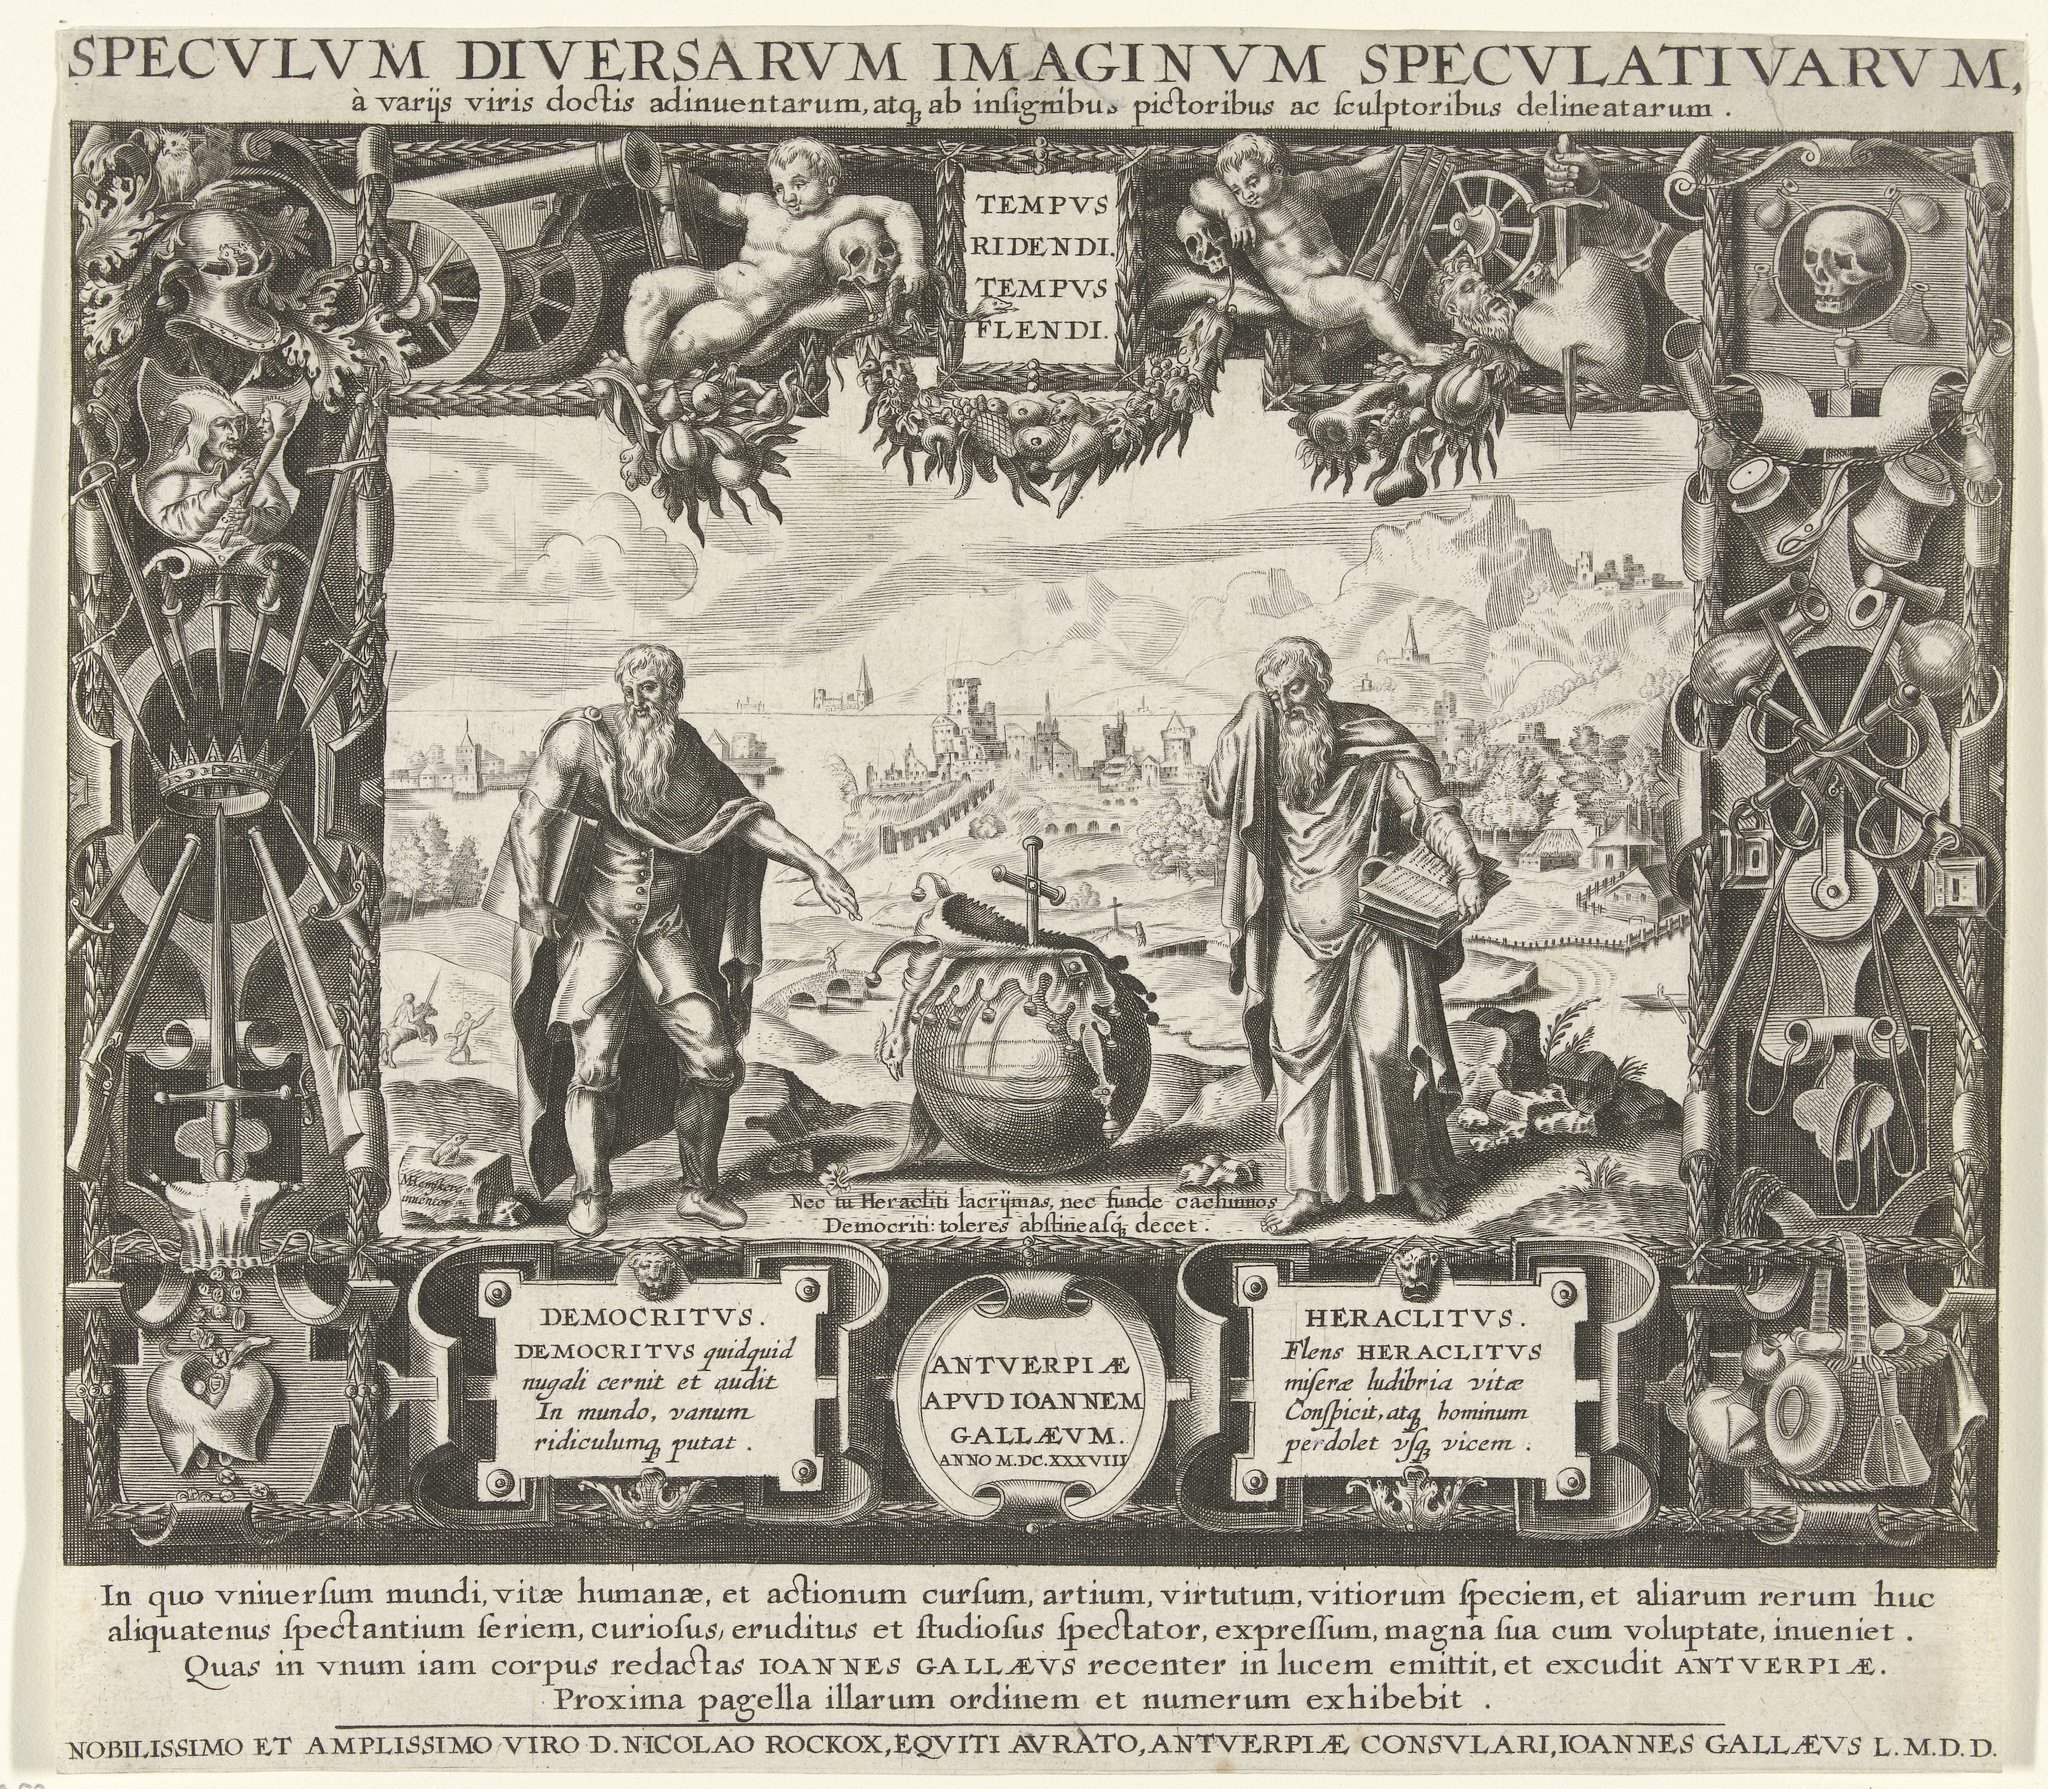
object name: print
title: Heraclitus en Democritus, of aansporing tot geduld en verdraagzaamheid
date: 1550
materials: paper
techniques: engraving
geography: haarlem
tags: fool, simpleton, numskull, folly, foolishness; 'pazzia', 'sciocchezza', 'stoltitia' (ripa), fool's cap, ornament derived from objects, heraclitus, the weeping philosopher, and democritus, the laughing philosopher (+ in allegorical or symbolic frame or setting; with allegorical or symbolic accessories)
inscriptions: collector's mark: Lugt 2228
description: Links staat Democritus, de lachende filosoof. Hij wijst naar een wereldbol. In zijn hand een boek. Aan de andere kant van de wereldbol Heraclitus, de huilende filosoof. Ook hij heeft een boek vast. Hij veegt zijn tranen weg met zijn toga. De wereldbol draagt een zotskap, verwijzend naar de dwaasheid van de wereld. De prent heeft een ornamentkader met allerlei wapentuig en twee putti. In cartouches boven en onderaan Latijnse teksten. Met een Latijns onderschrift.